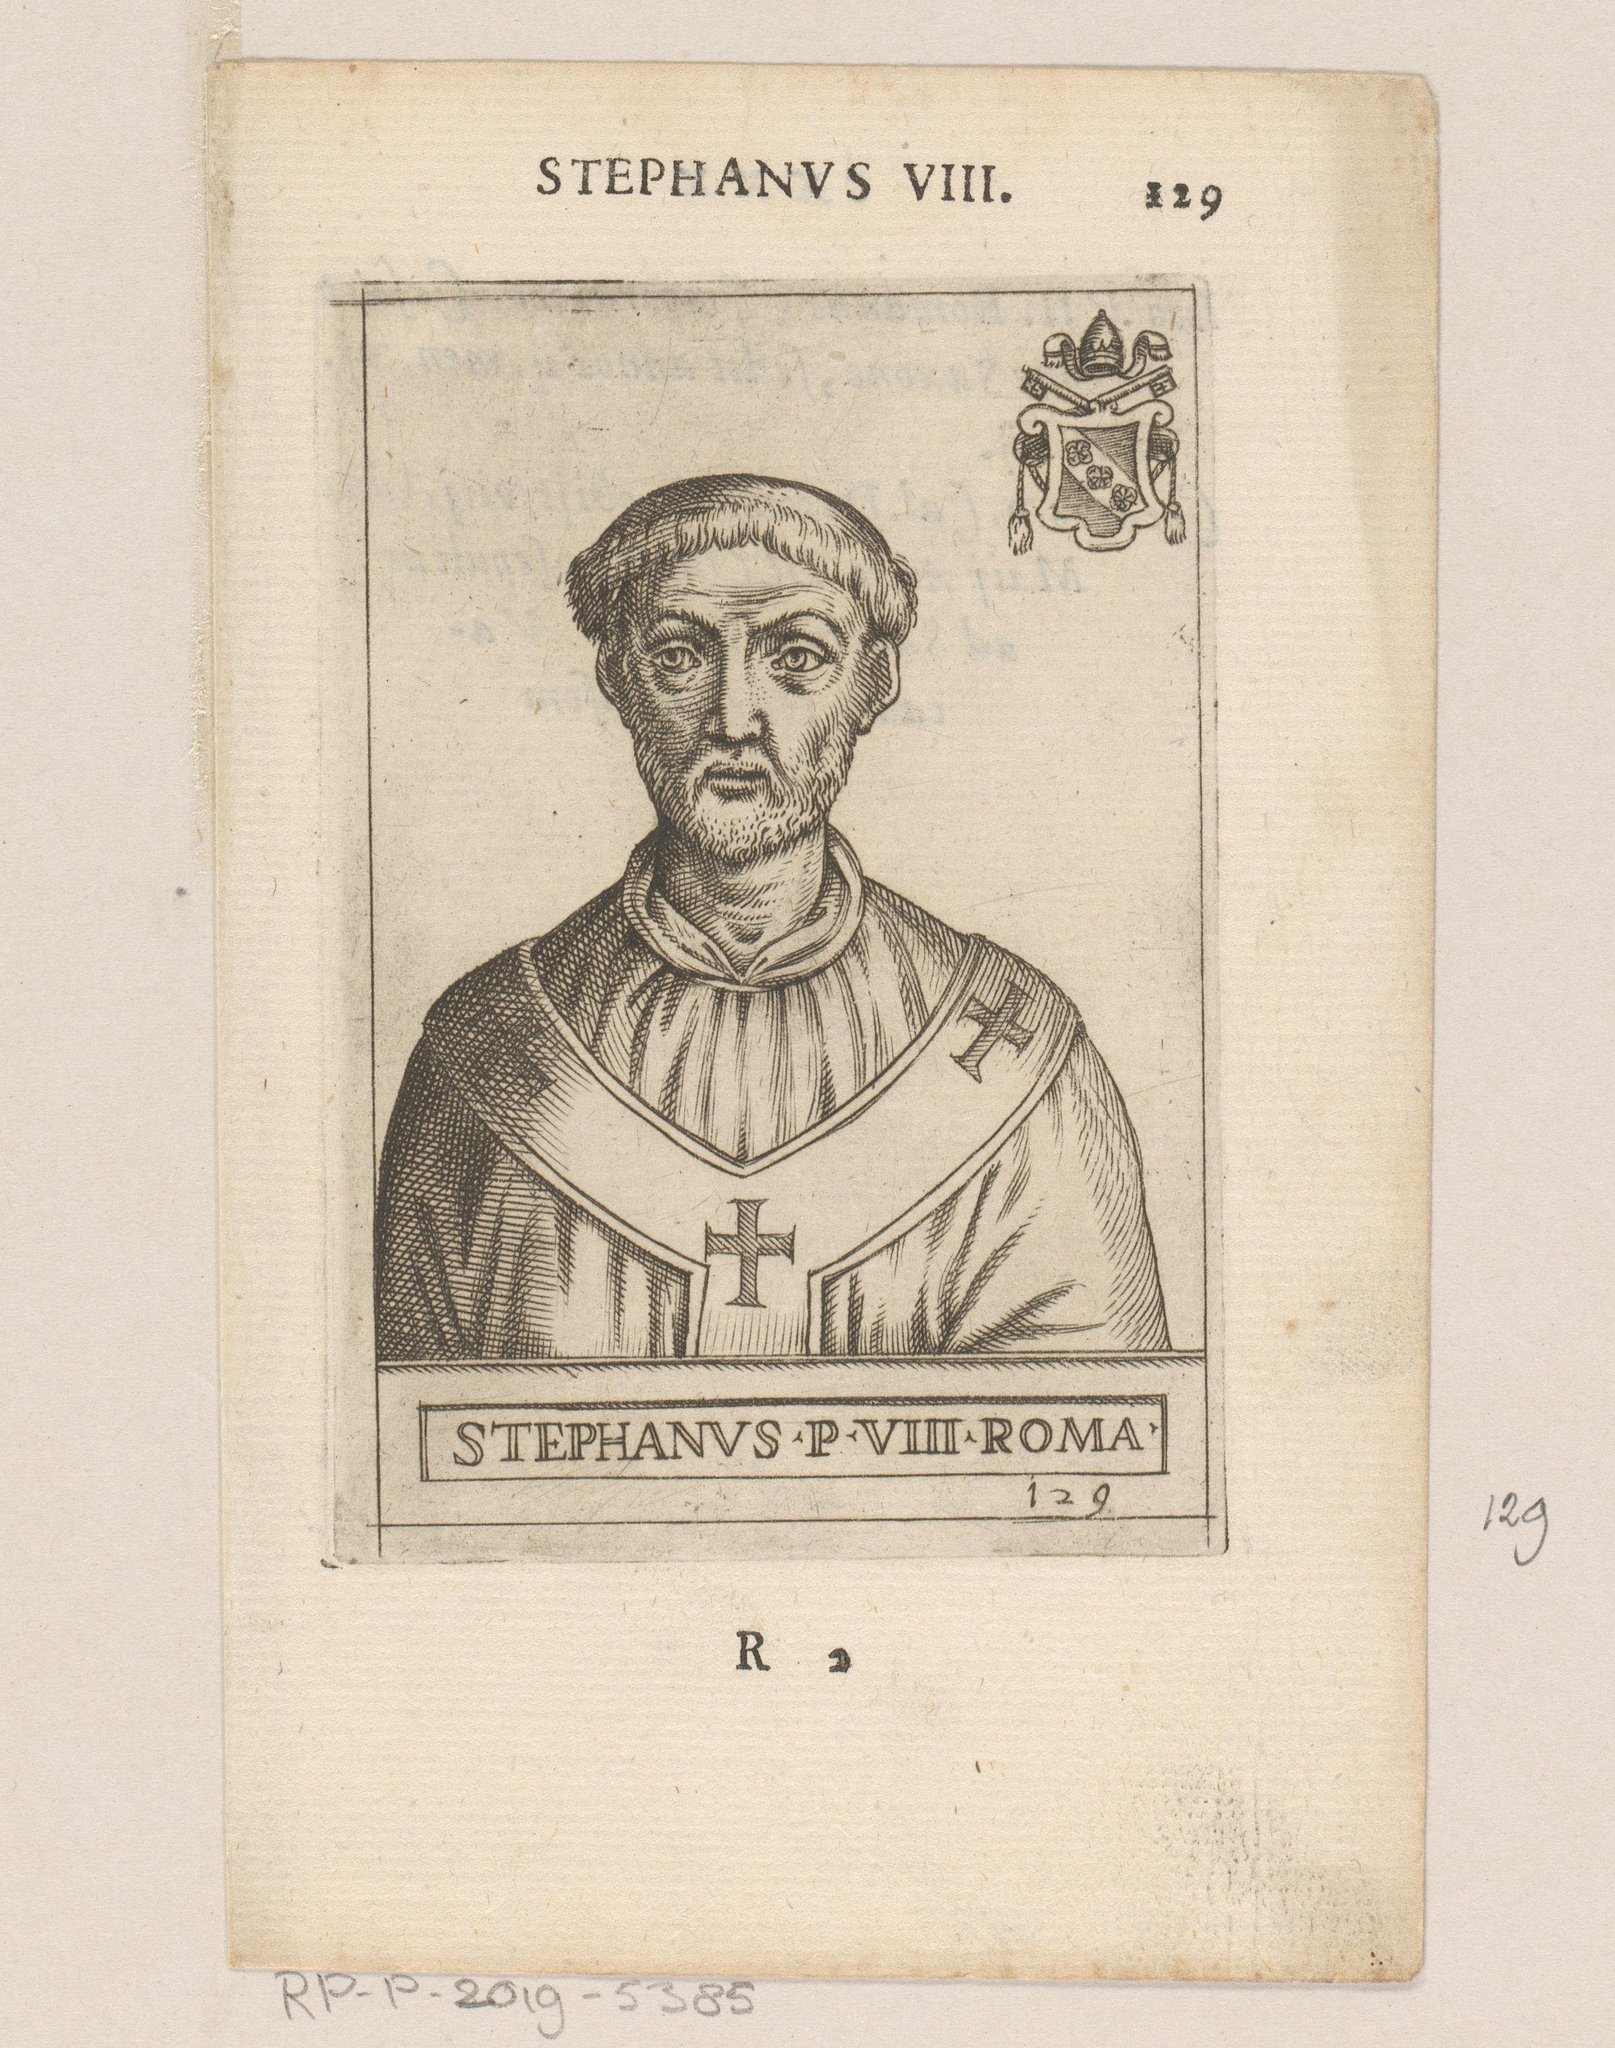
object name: print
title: Stephanus P VIII Roma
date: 1595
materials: paper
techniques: engraving, letterpress printing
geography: rome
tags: historical persons, pope, armorial bearing, heraldry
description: Prent uit: Cavalieri, Giovanni Battista de'. Effigies pontificum romanorum cum eorum vitis (...). Rome: Bartolomeo Bonfadino, 1595. Prent voor het eerst verschenen in: Cavalieri, Giovanni Battista de'. Pontificum romanorum effigies (...). Rome: Domenico Basa en Francesco Zanetti, 1580. Prent ook gebruikt in latere publicaties.